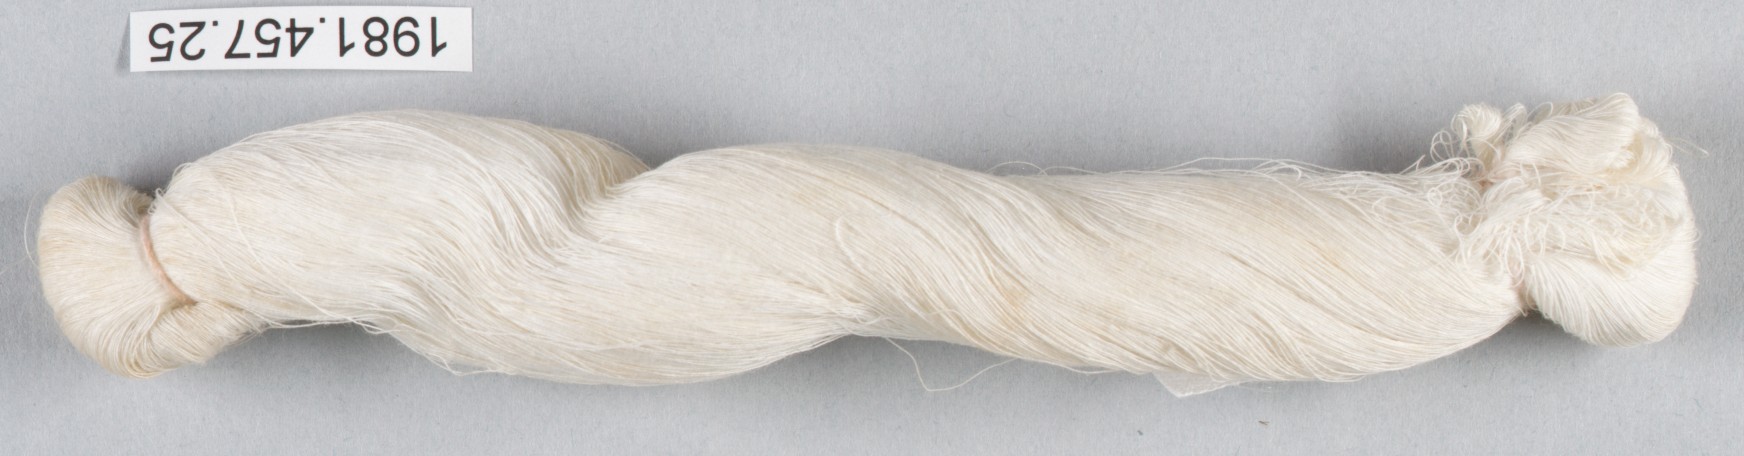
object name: skein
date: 1840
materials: cotton